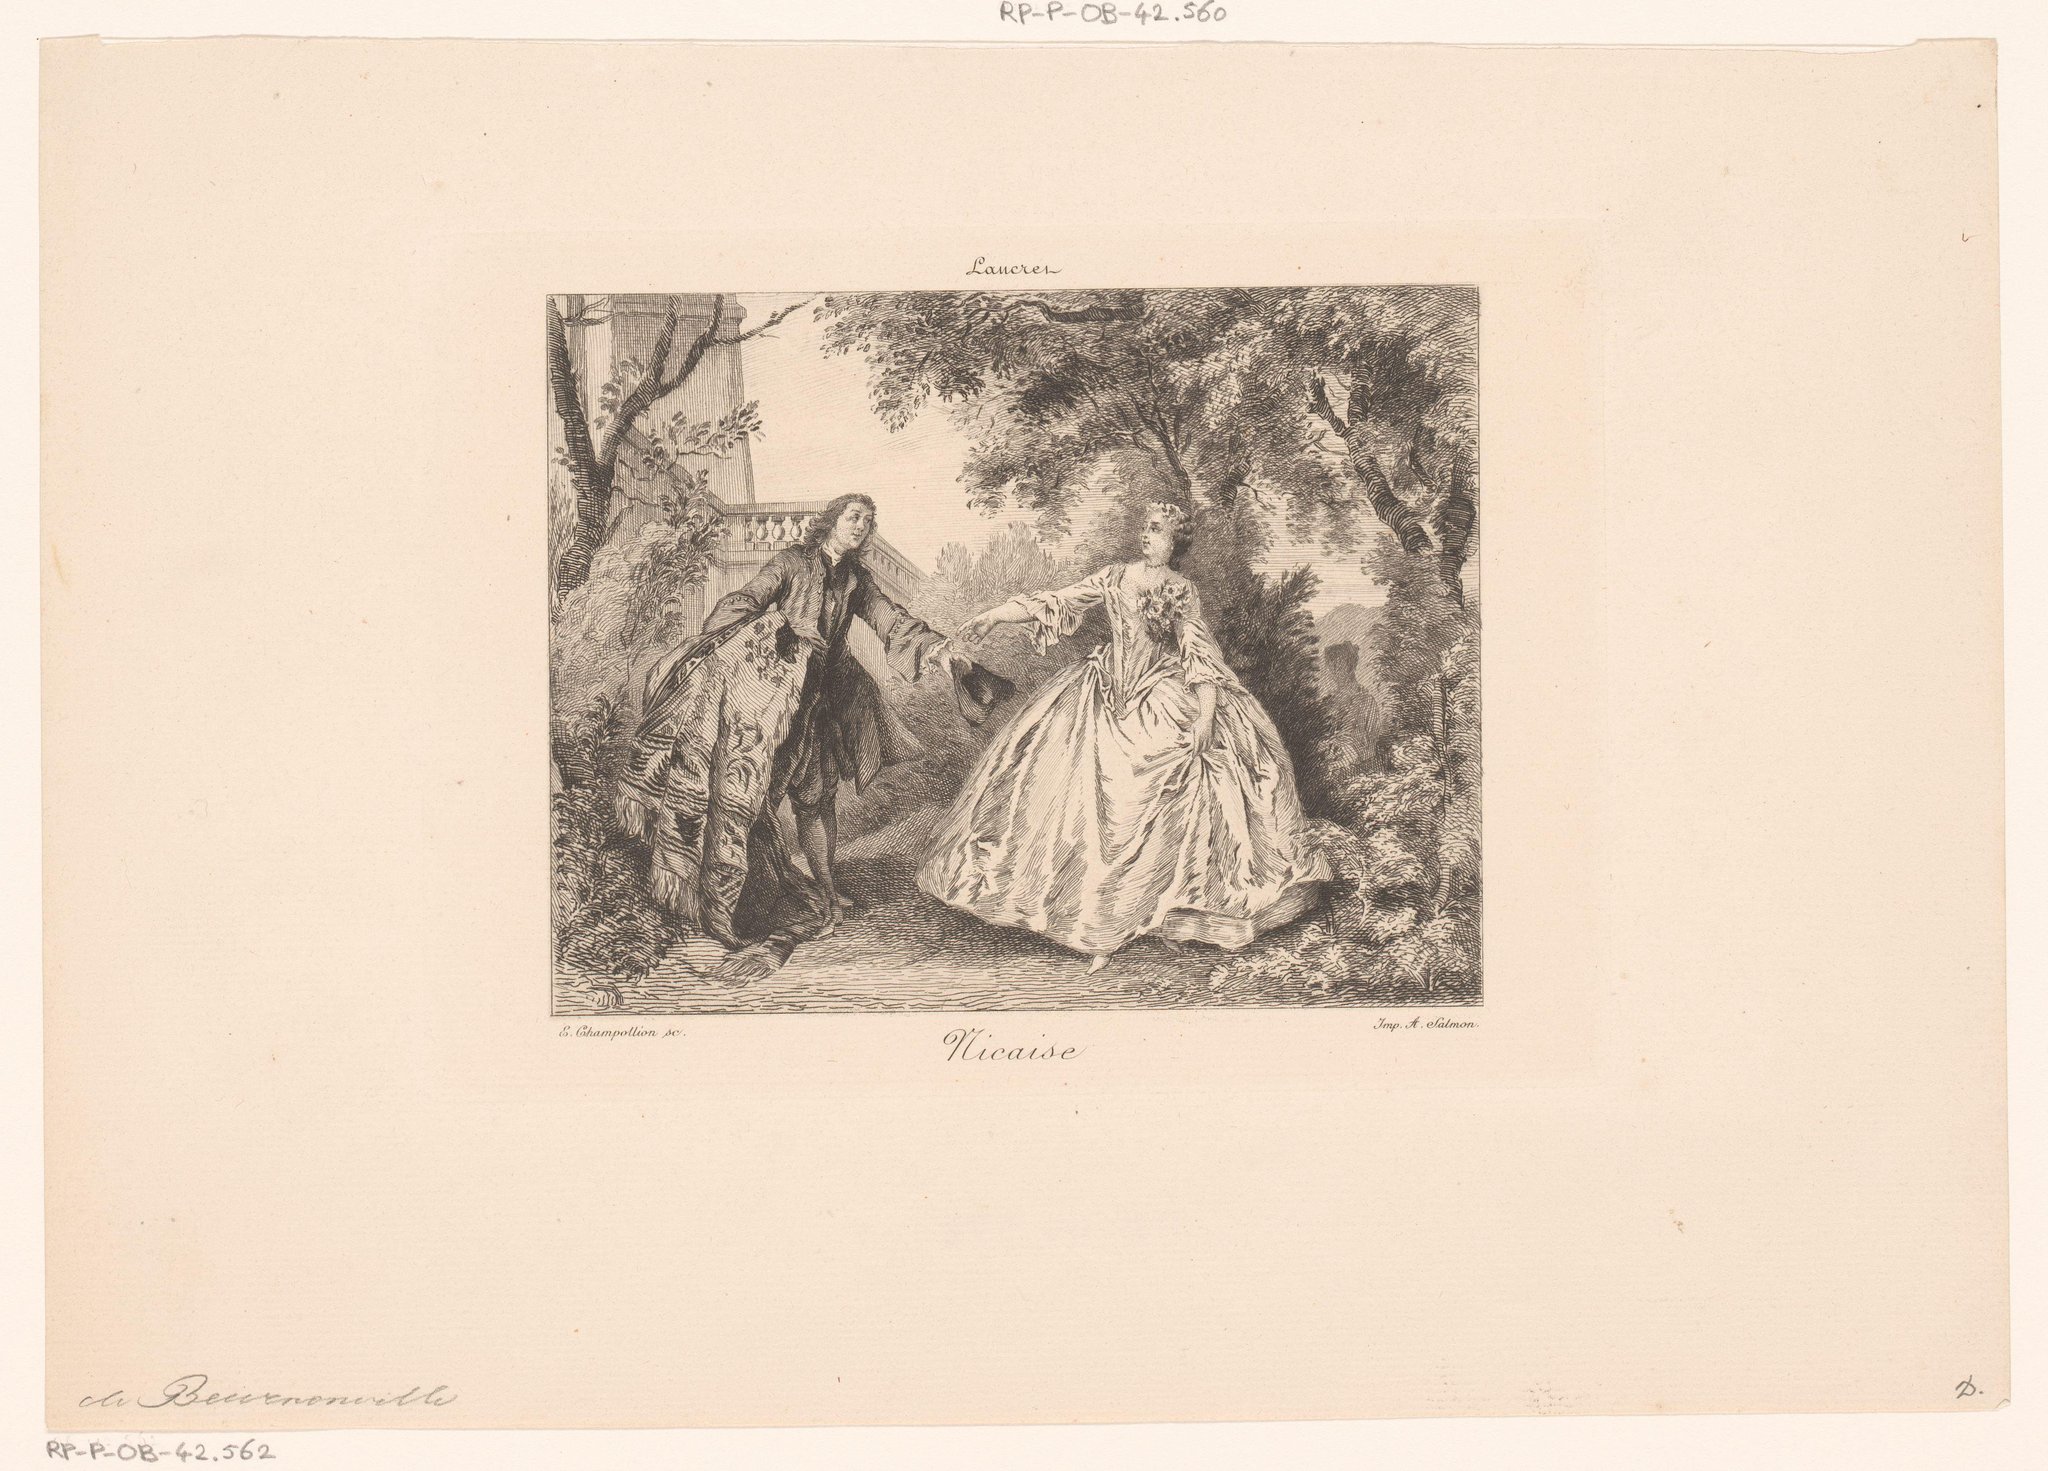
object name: book illustration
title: Nicaise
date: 1881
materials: paper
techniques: etching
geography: france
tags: garden, lovers; courting, flirting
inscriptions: collector's mark: Lugt 2228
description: Prent afkomstig uit een veilingcatalogus: "Catalogue des Tableaux anciens composant la très importante collection de Monsieur le Baron de Beurnonville", uitgegeven in 1881 te Parijs door Pillet en Dumoulin. De veiling vond plaats van 9 tot en met 14 en 16 mei 1881.